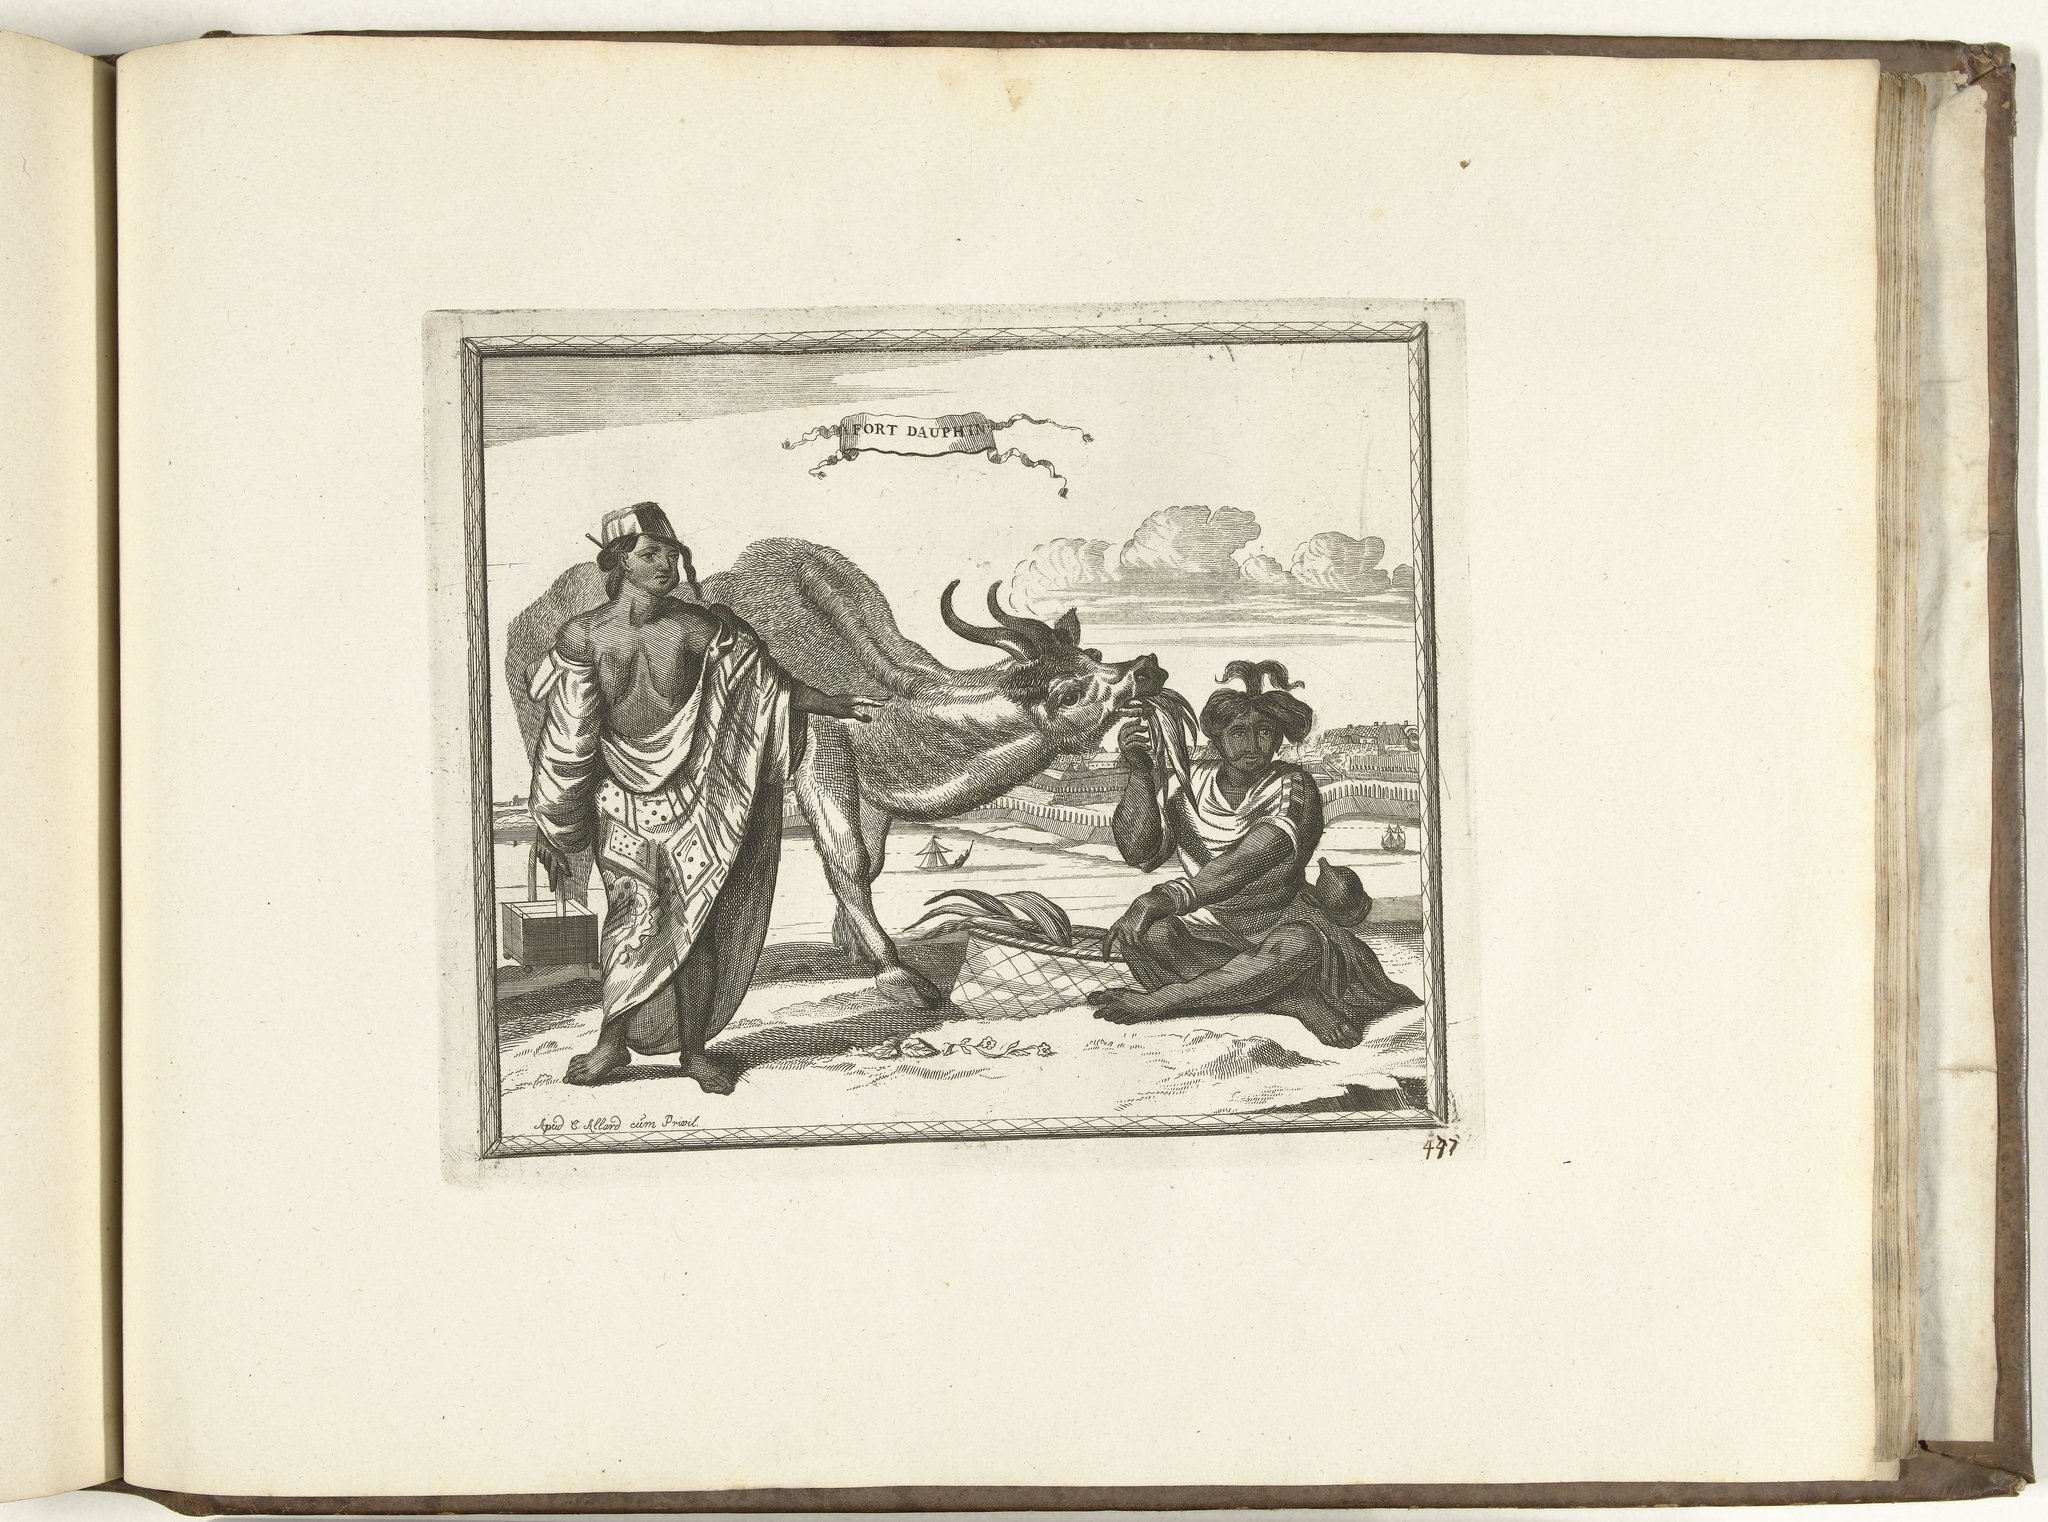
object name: costume print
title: 't Fort Dauphin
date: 1726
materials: paper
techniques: etching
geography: leiden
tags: africans, folk costume, regional costume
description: Man en vrouw van Faradofay (Fort Dauphin) op Madagaskar, gekleed in lokaal kostuum. Op de achtergrond de stad. Plaat nr. 477 in deel XIX van het prentwerk: Les Forces de l'Europe, Asie, Afrique et Amerique ... Comme aussi les Cartes des Côtes de France et d'Espagne uit 1726, dit tweede deel met 271 met de hand genummerde platen van vermaarde sterke steden en vestingen in het kader van de Spaanse Successieoorlog 1701-1713. Voor het merendeel zijn deze platen gekopieerd naar de anonieme Franse platen van vermaarde sterke steden en vestingen: in Les forces de l'Europe en in: Le theatre de la guerre, dans les Pays-Bas, beide oorspronkelijk uitgegeven door Nicolas de Fer te Parijs (1693-1697) in het kader van de Negenjarige Oorlog.